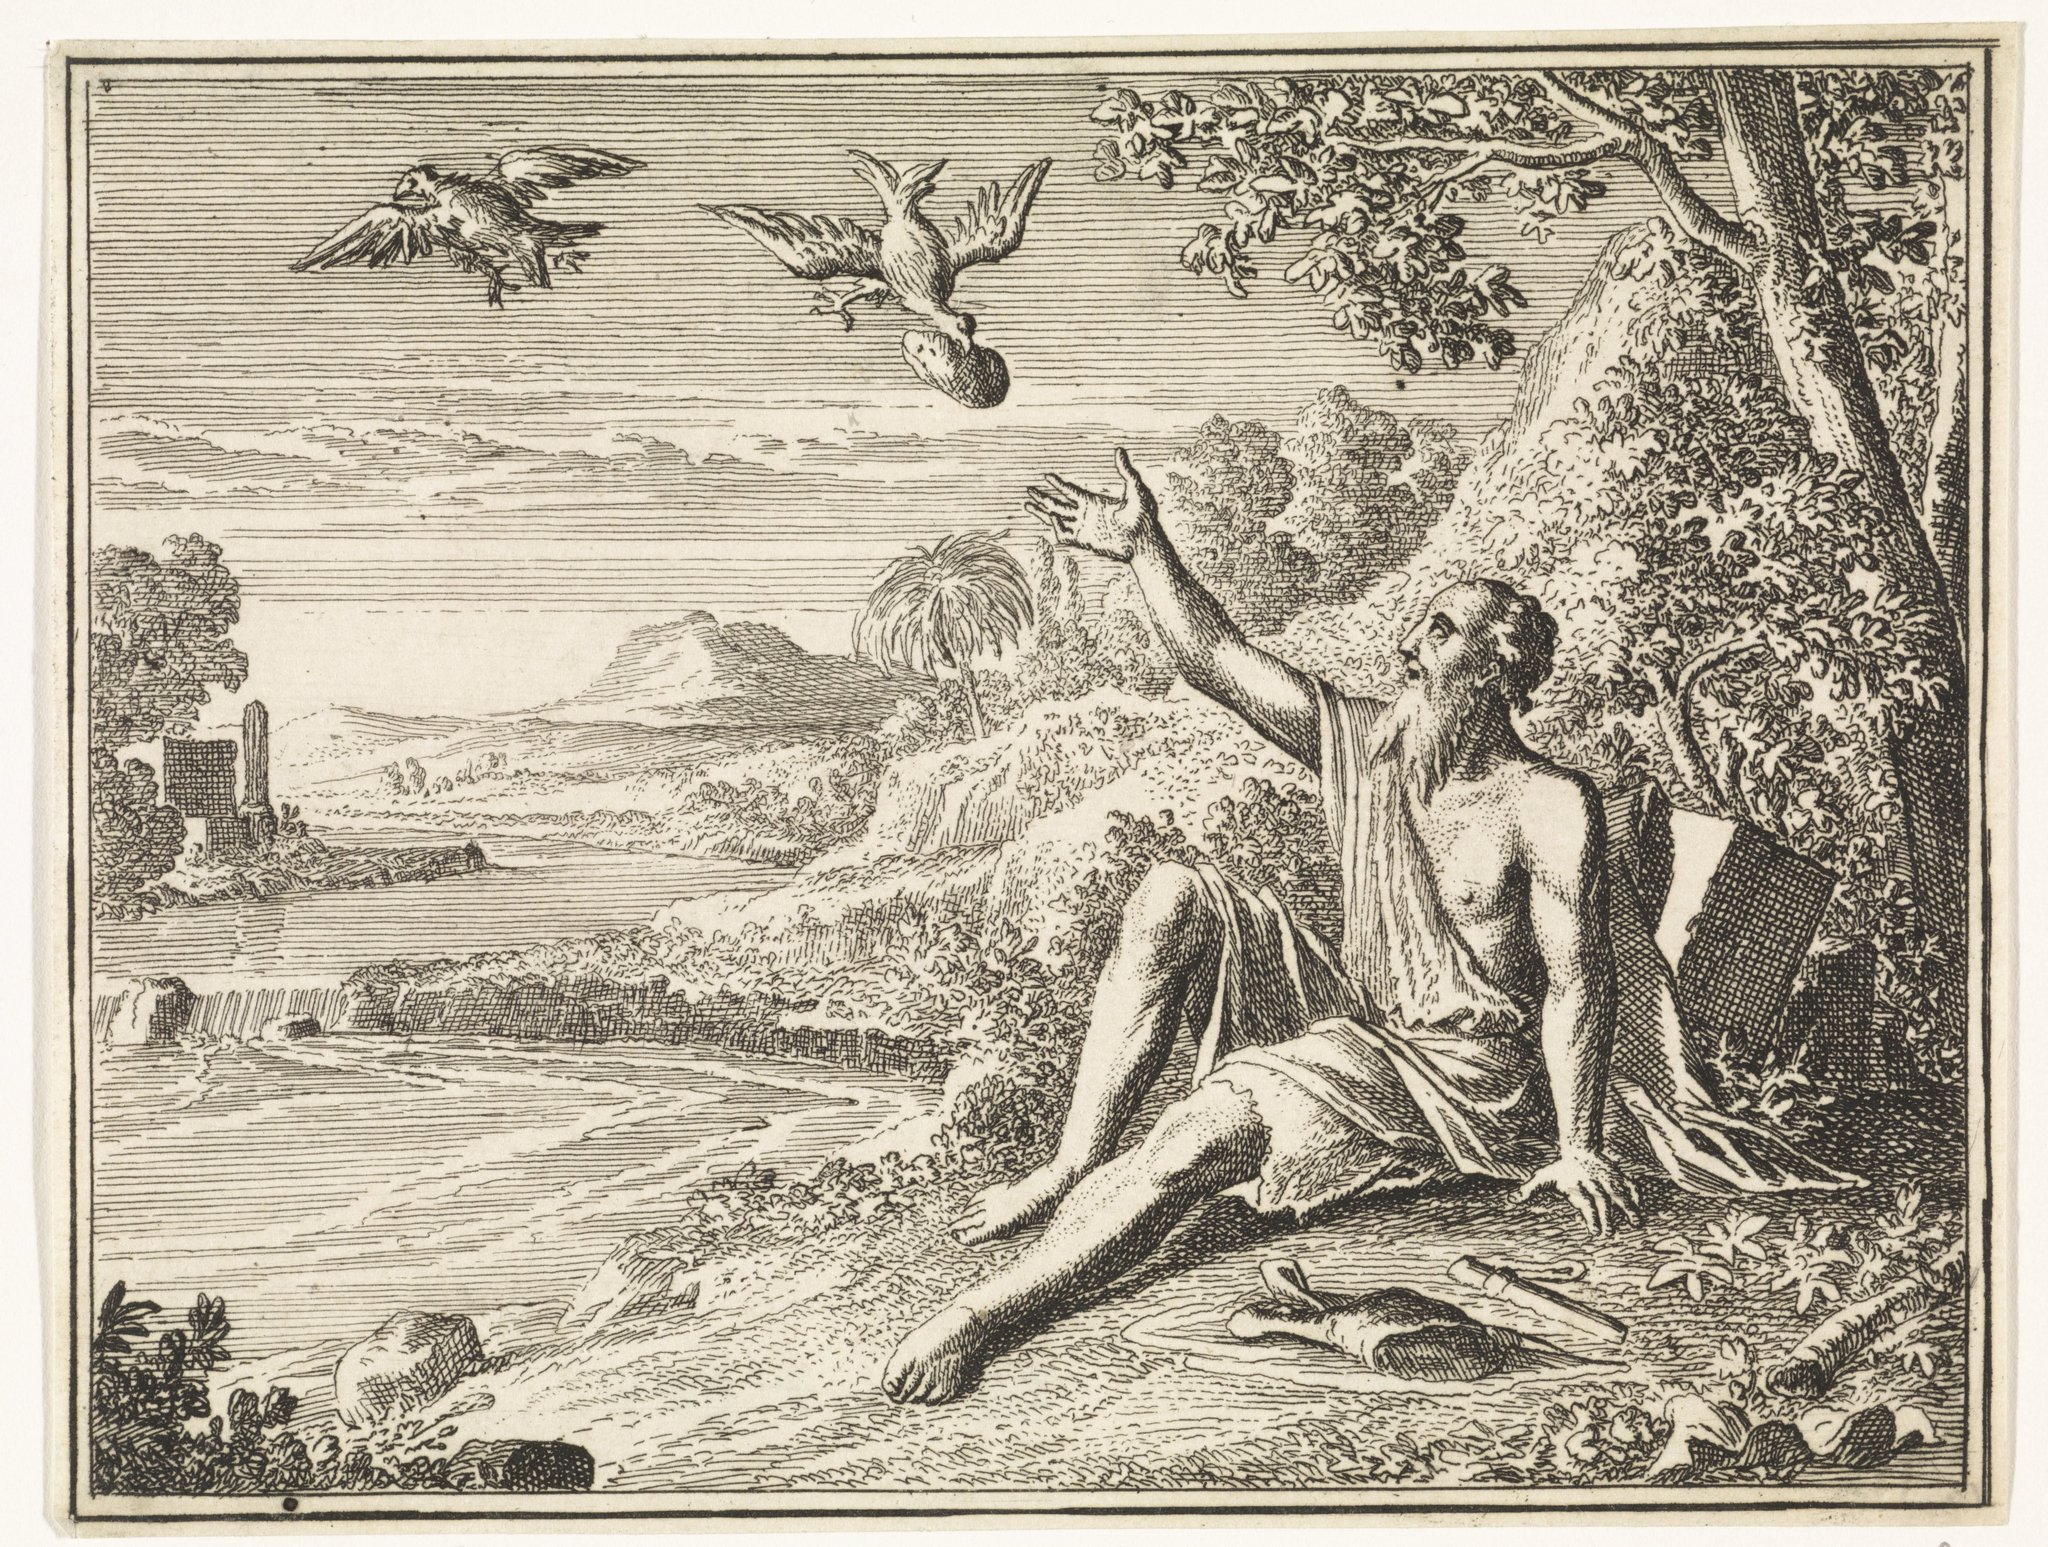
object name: print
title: Elia door de raven gevoed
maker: caspar luyken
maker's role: draughtsman, print maker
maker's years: 1672-1708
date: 1712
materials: paper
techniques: etching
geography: amsterdam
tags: elijah fed by the raven(s): while the prophet is living by the brook, ravens bring him food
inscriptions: number: ‘131’, collector's mark: Lugt 2228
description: Illustratie uit: Luyken, Jan. De schriftuurlyke geschiedenissen en gelykenissen van het Oude en Nieuwe Verbond, 2 delen. Amsterdam: Wed. Pieter Arentsz II en Cornelis van der Sys, 1712, dl. I.